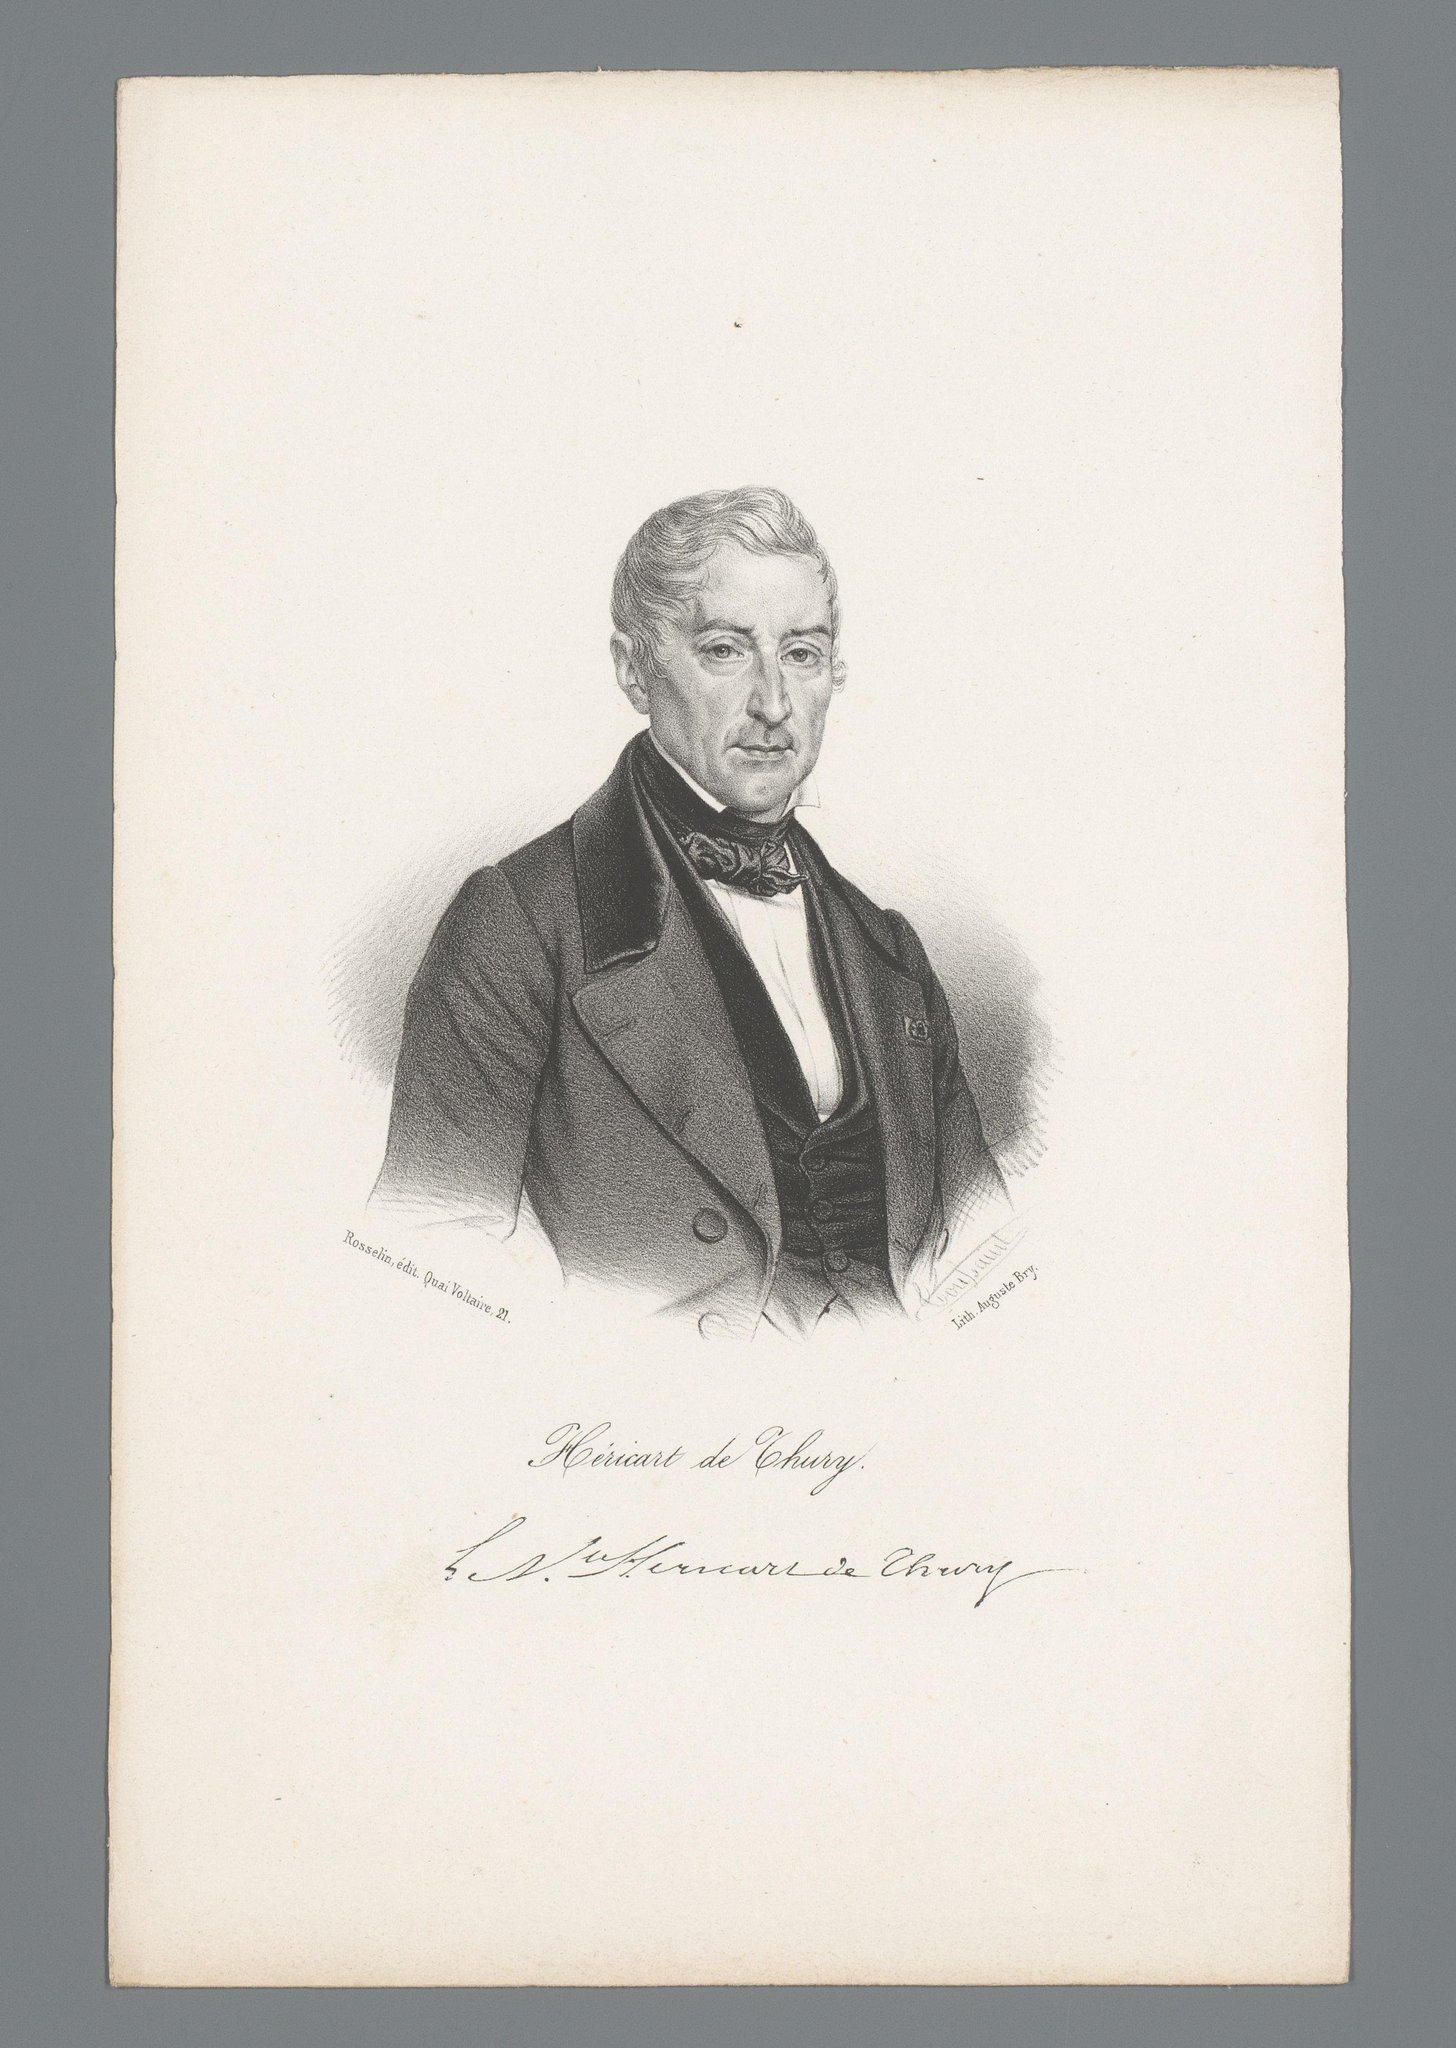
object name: print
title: Héricart de Thury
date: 1847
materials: paper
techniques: lithograph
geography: paris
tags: paris, rome, politician, historical persons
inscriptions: collector's mark: Lugt 2228